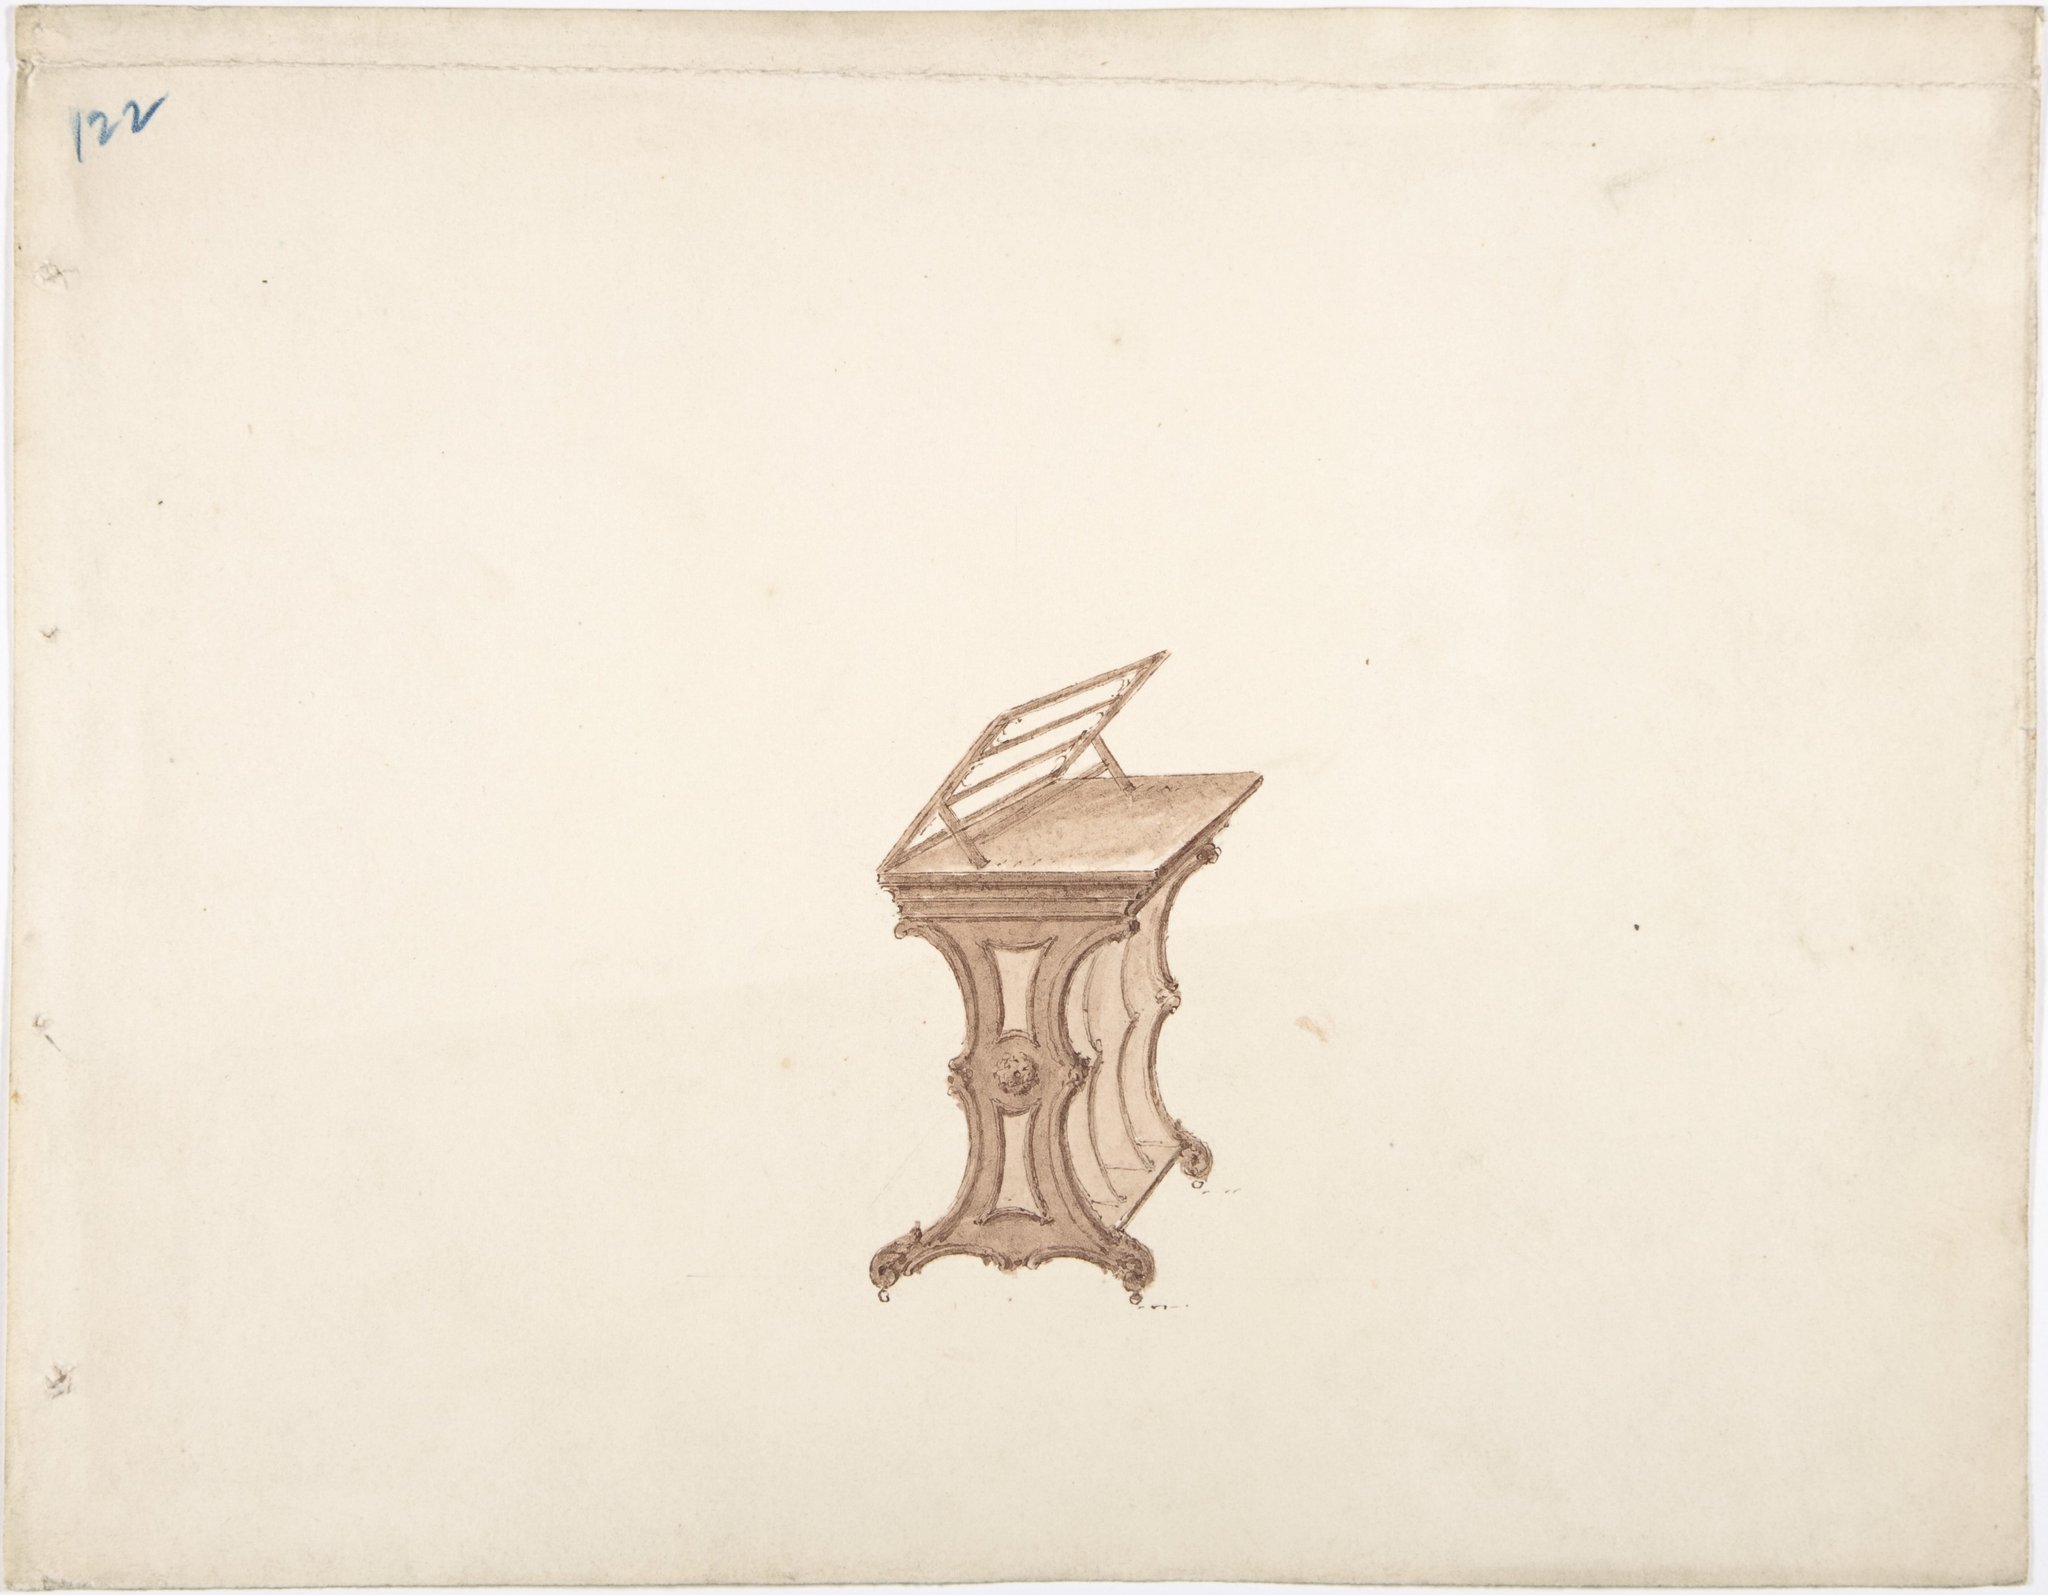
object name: drawing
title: Design for a Bookstand on Casters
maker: anonymous, british, 19th century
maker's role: artist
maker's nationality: british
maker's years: 1800-1900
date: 1801-1833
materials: ink, watercolor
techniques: pen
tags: furniture